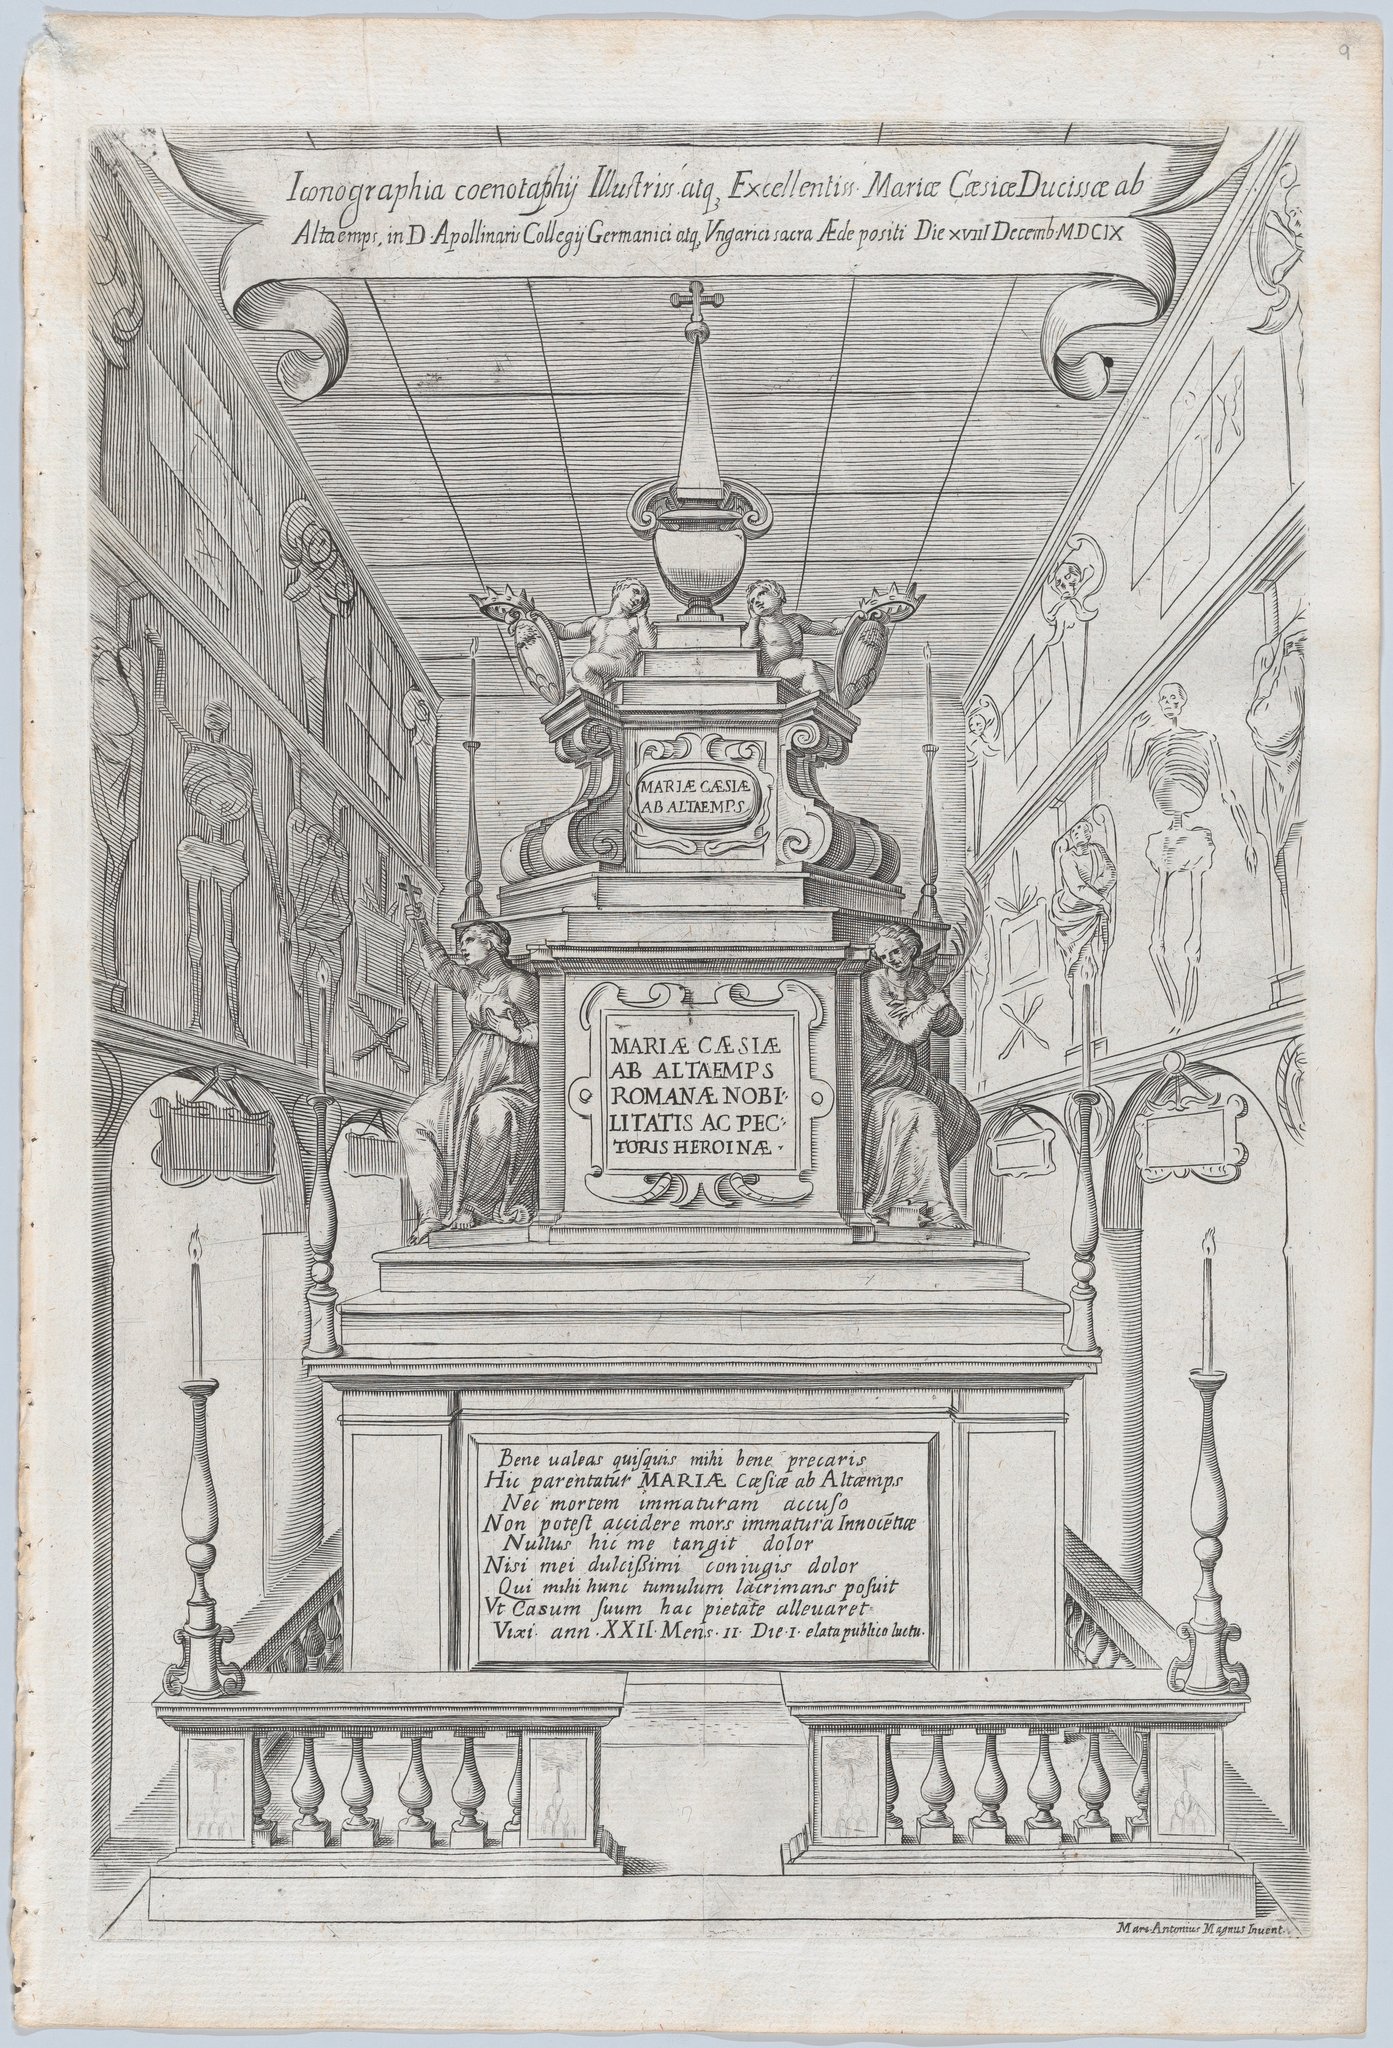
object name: print, fete, ornament architecture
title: Catafalque for Duchess Maria Cesi of Altemps (Hohenems); from 'Libro De Catafalchi, Tabernacoli, con varij designi di Porte fenestre et altri ornamenti di Architettura'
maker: marcus antonius magnus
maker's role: artist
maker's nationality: italian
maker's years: 1064-1614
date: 1609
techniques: engraving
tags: women